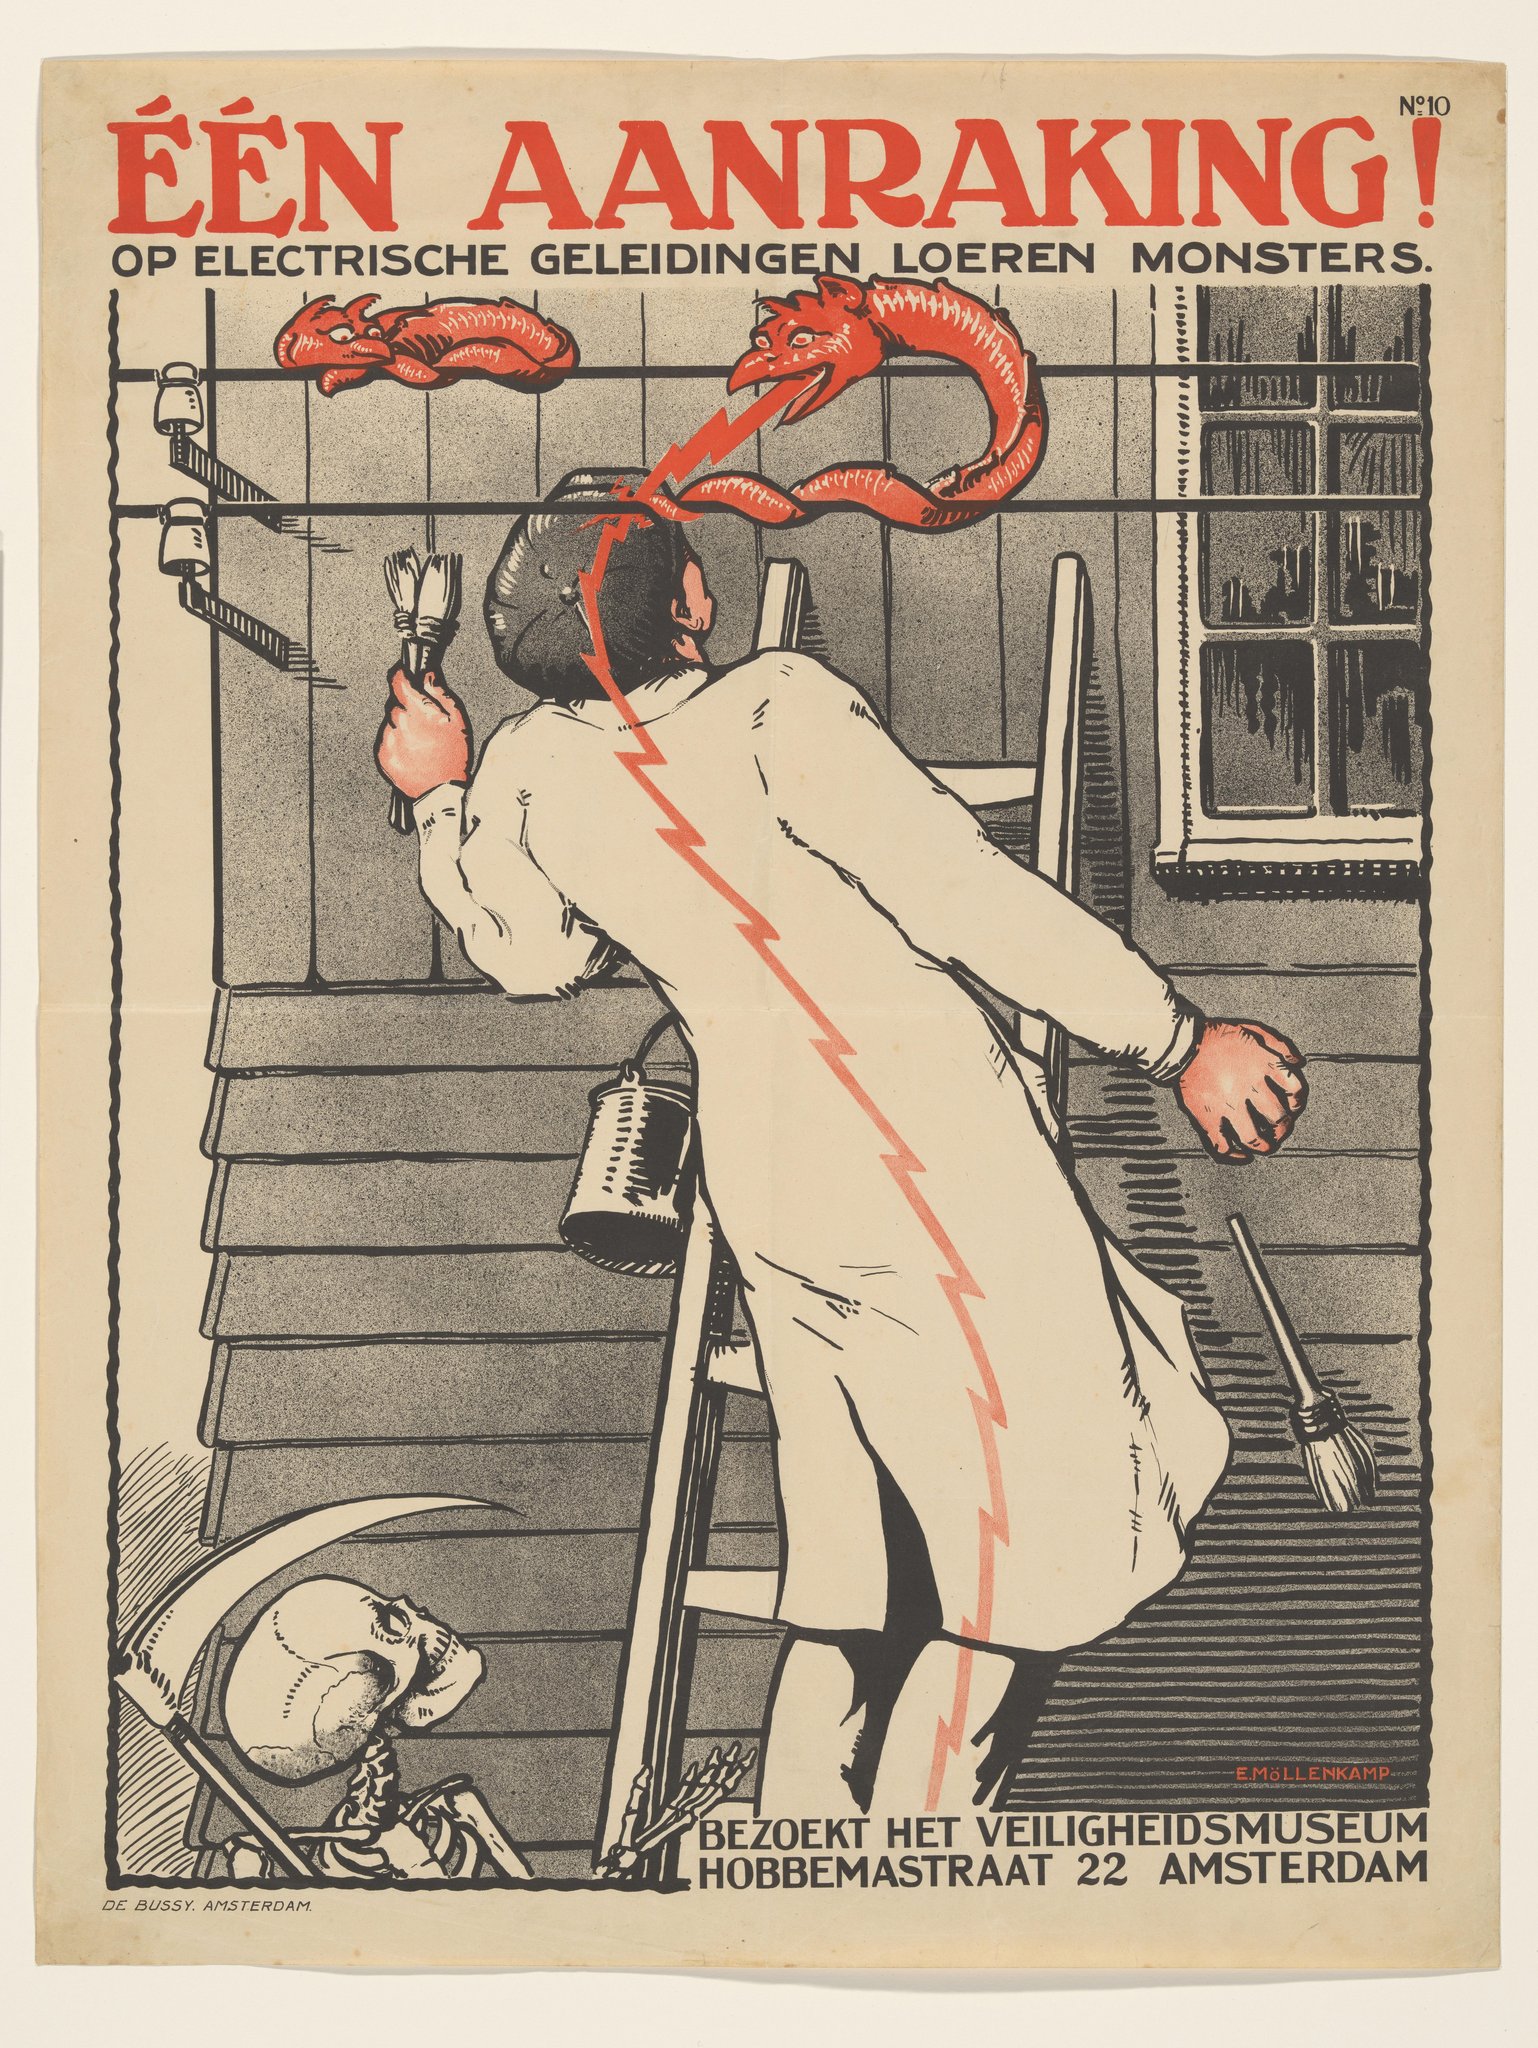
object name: poster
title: Een aanraking!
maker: evert möllenkamp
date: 1920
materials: paper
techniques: lithograph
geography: netherlands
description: poster uitgegeven door het Veiligheids Instituut/Veiligheids Museum